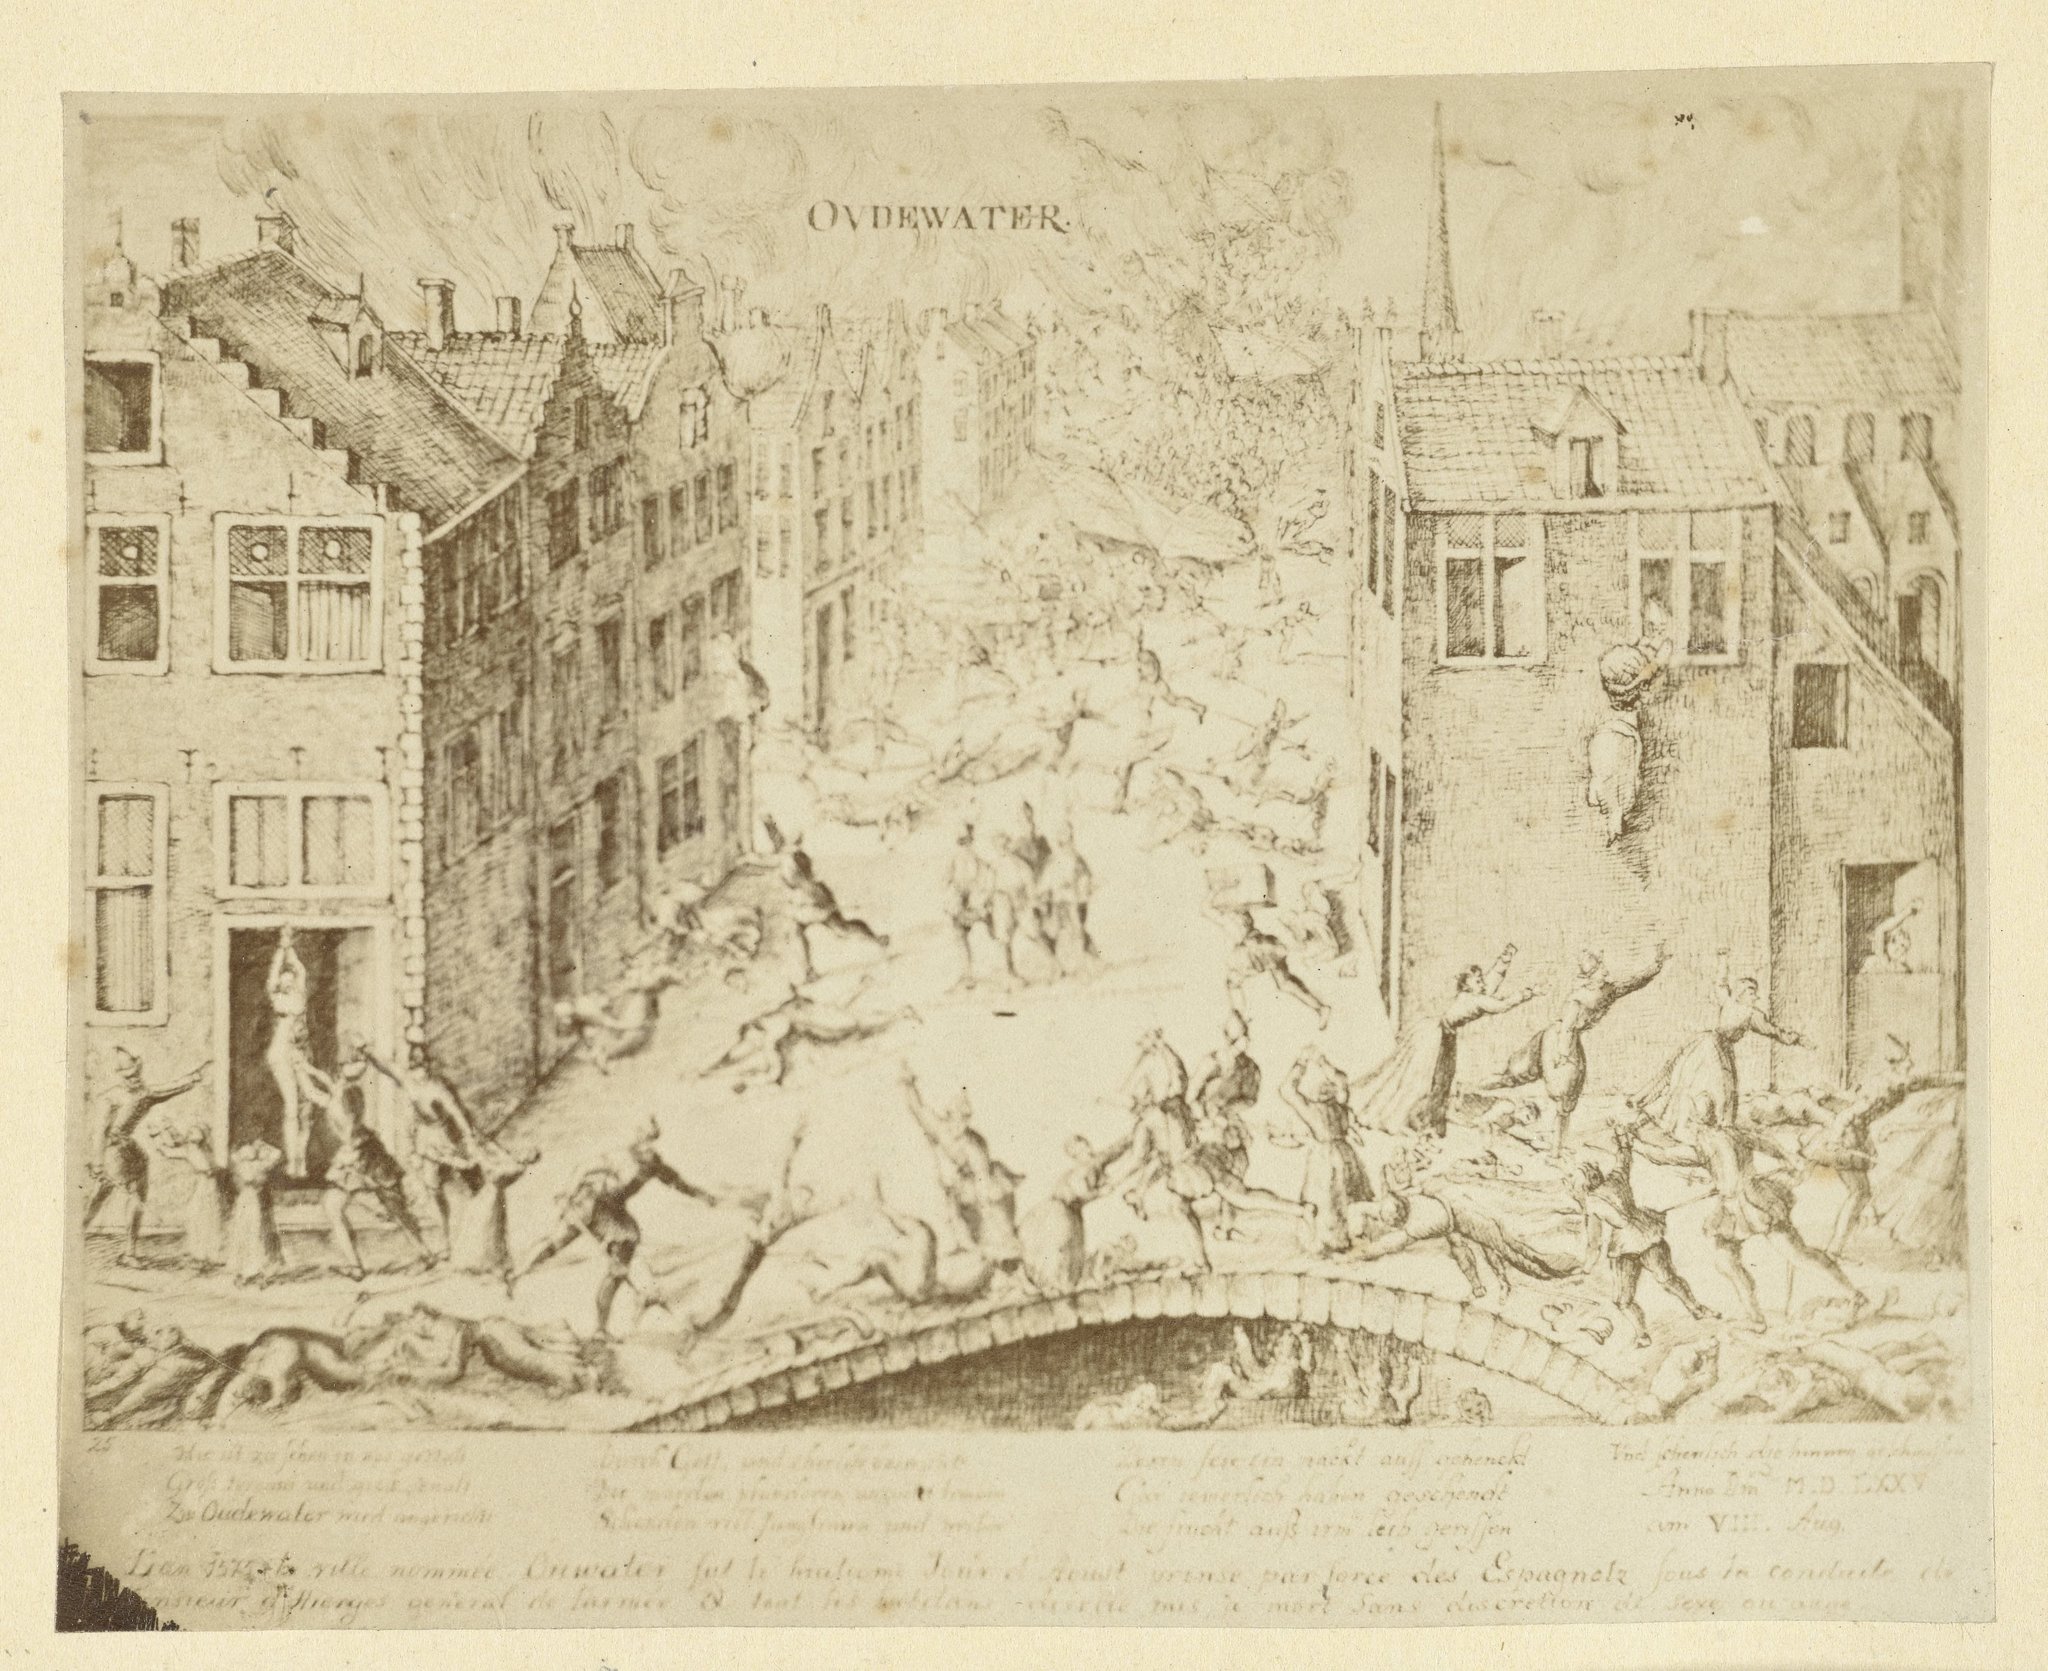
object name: historical object representation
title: Prent van de plundering en moord te Oudewater, 1575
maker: eberhard cornelis rahms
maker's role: print maker, publisher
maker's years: 1823-1907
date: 1876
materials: photographic support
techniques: photography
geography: netherlands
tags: maastricht, politician, massacre ~ war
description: Illustratie in: J. van Heerde & E.C. Rahms, Gedenkboek van Oudewater's beleg en moord in 1575, E.C. Rahms, Oudewater [1876], p. 16/17. In het exemplaar in de Rijksmuseum Research Library met signatuur 34 E 13.